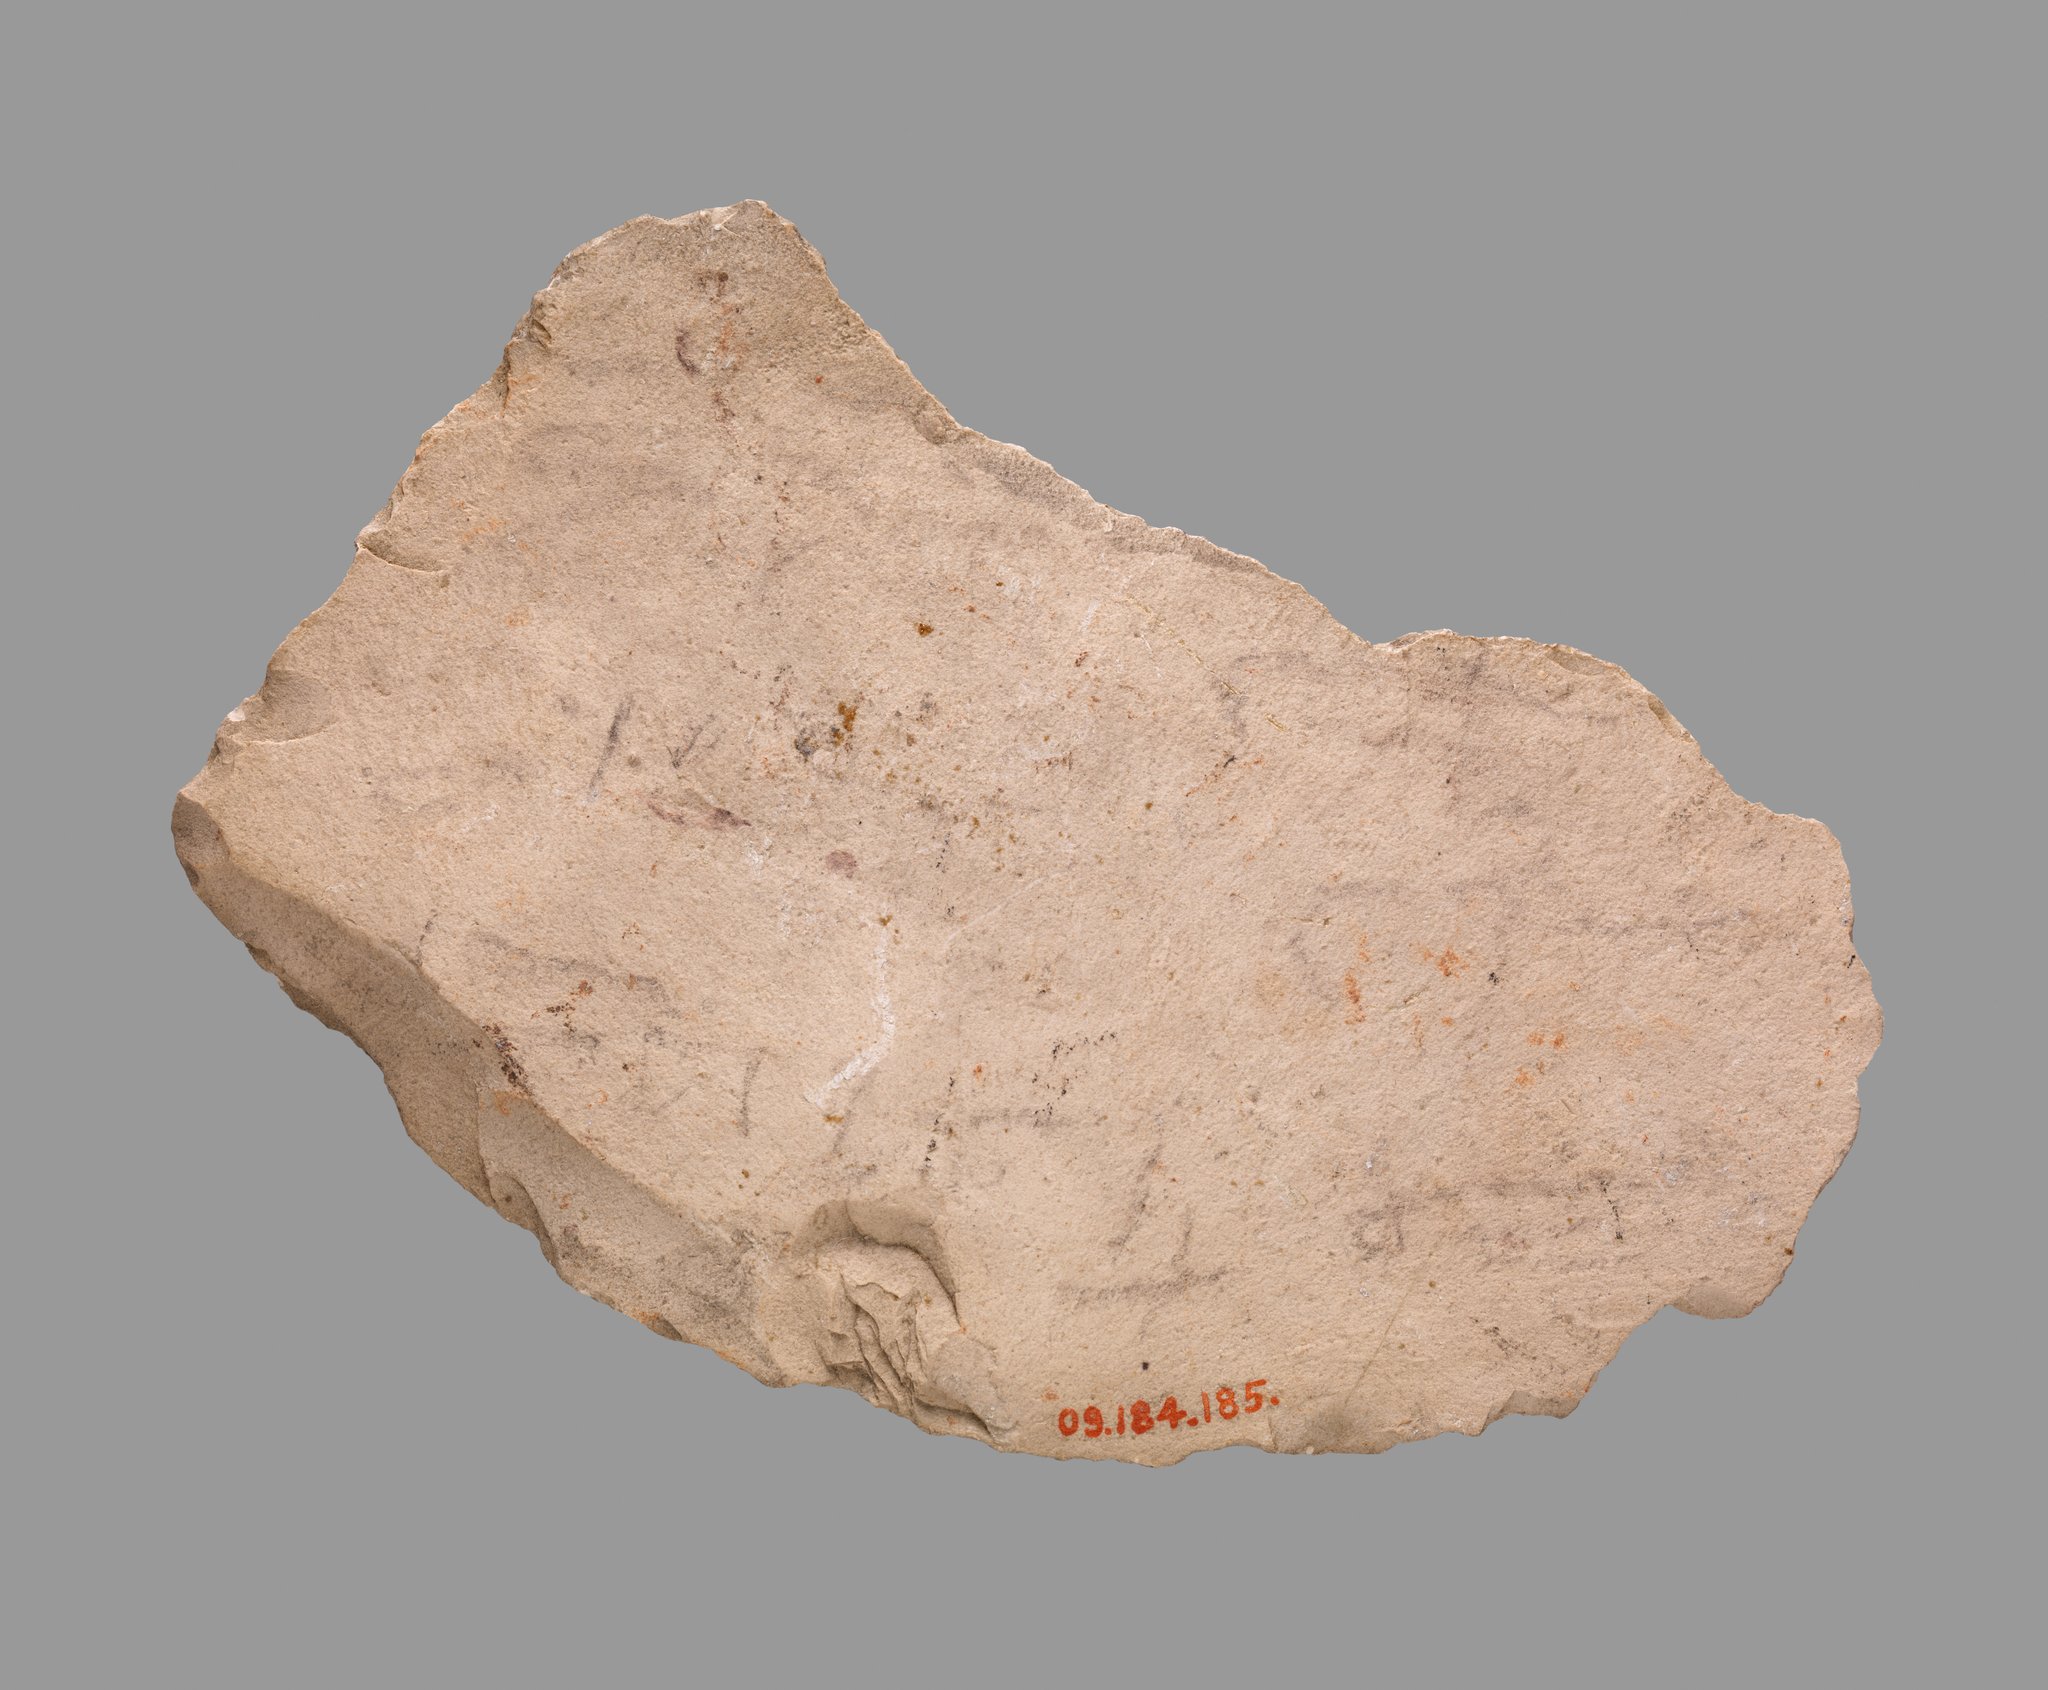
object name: ostracon, hieratic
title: Hieratic Ostracon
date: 1186-1070 BCE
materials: ink, limestone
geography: egypt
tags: hieratic